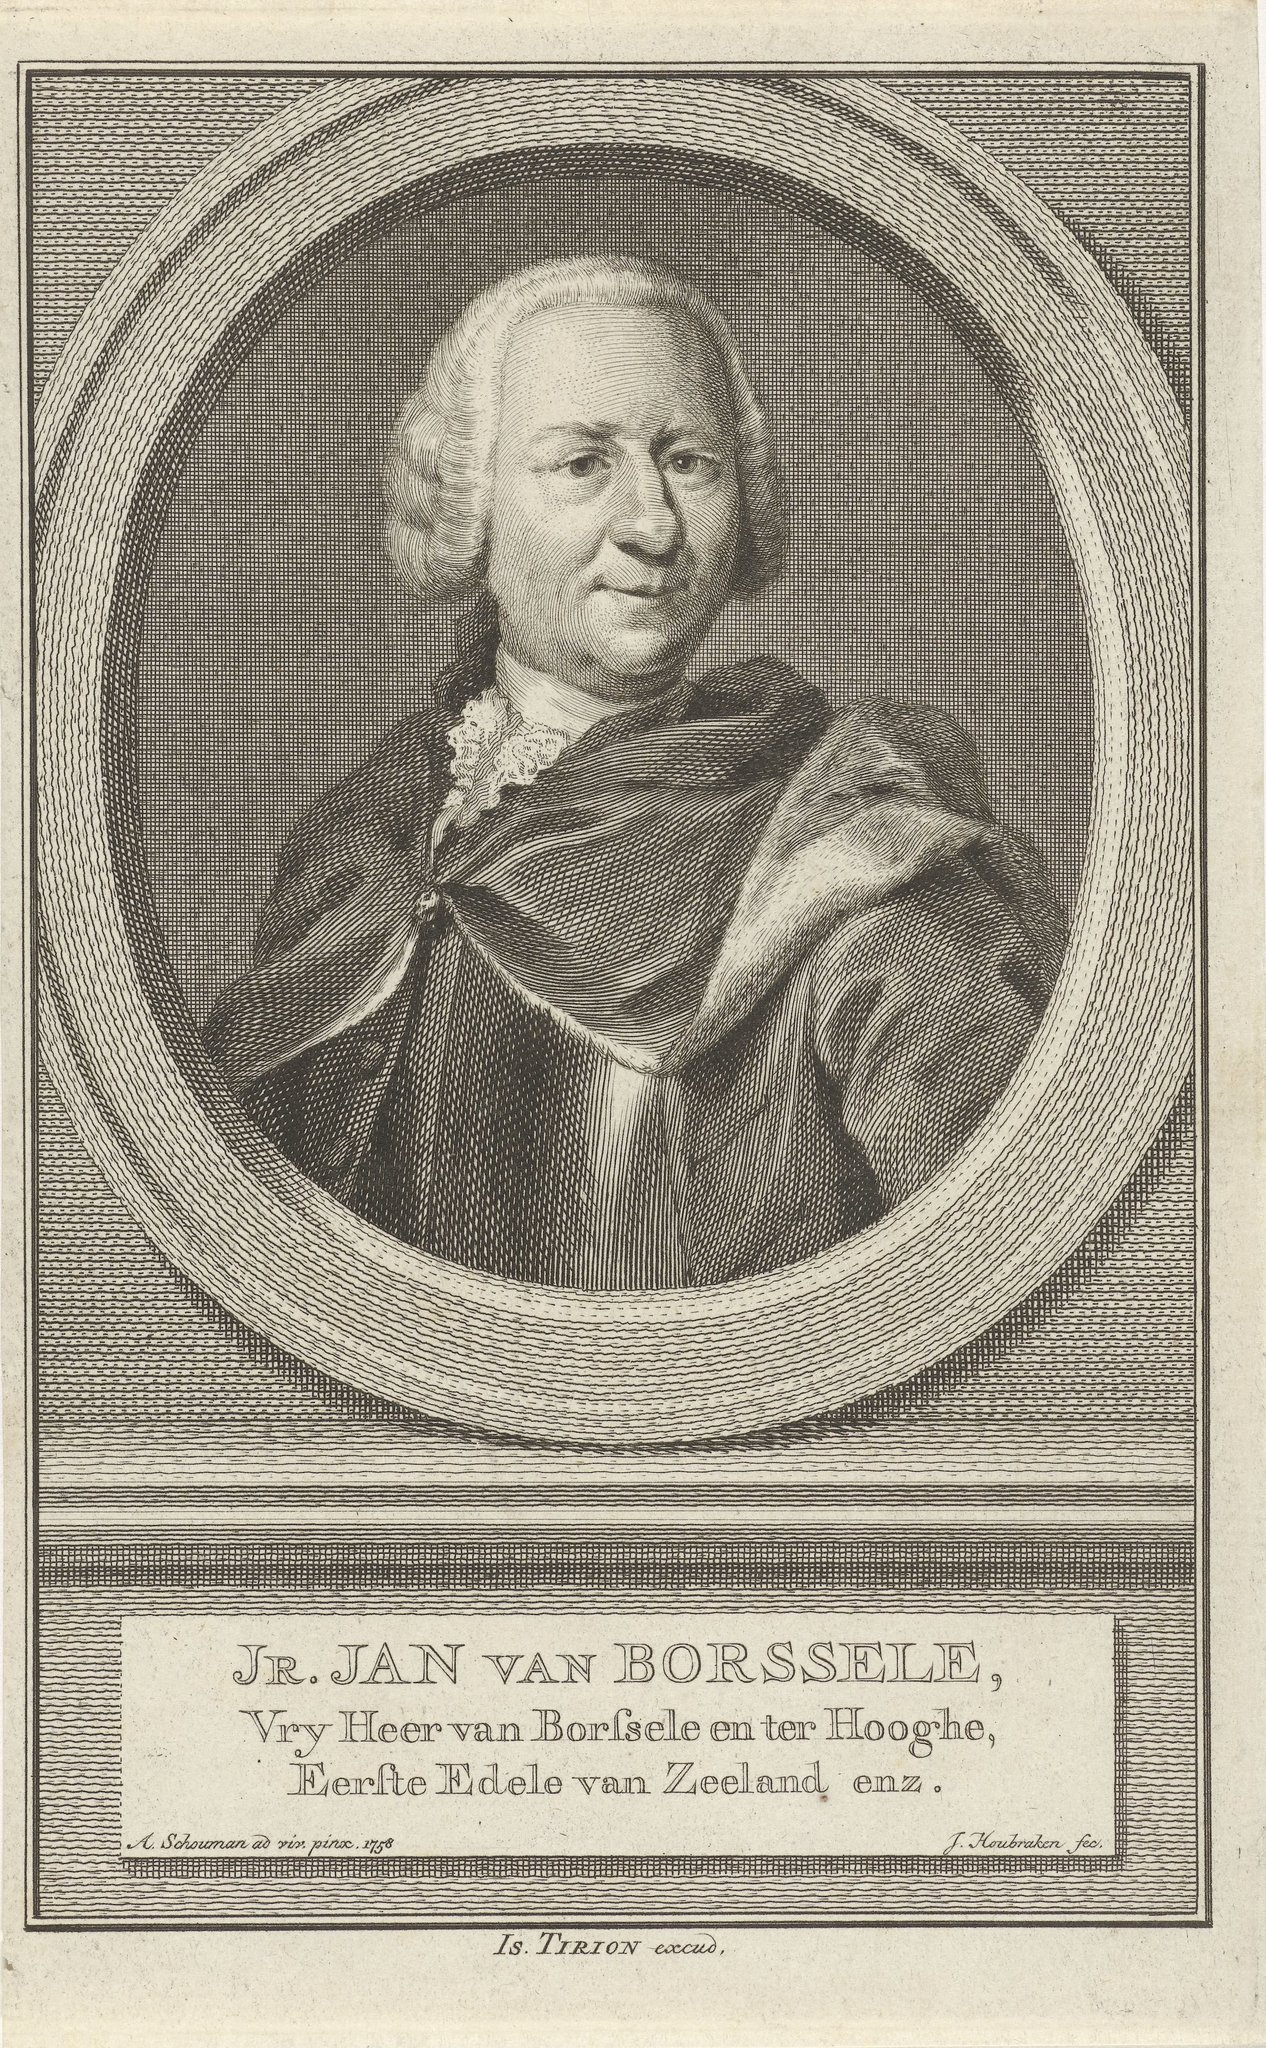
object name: print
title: Portret van Jan, heer van Borssele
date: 1749-1759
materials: paper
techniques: engraving, etching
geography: amsterdam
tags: the hague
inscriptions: collector's mark: Lugt 2228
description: Prent ook gebruikt in: Jan Wagenaar, Vaderlandsche historie, vervattende de geschiedenissen der nu Vereenigde Nederlanden, inzonderheid die van Holland (...), 21 delen. Amsterdam, Isaak Tirion, 1749-59. Prent ook gebruikt in: Portraiten van eenige der vermaardste staatsmannen en zeehelden, als toevoeging op: Willem Tiberius Hattinga, Atlas van Zeeland. Amsterdam: Isaak Tirion, 1760.